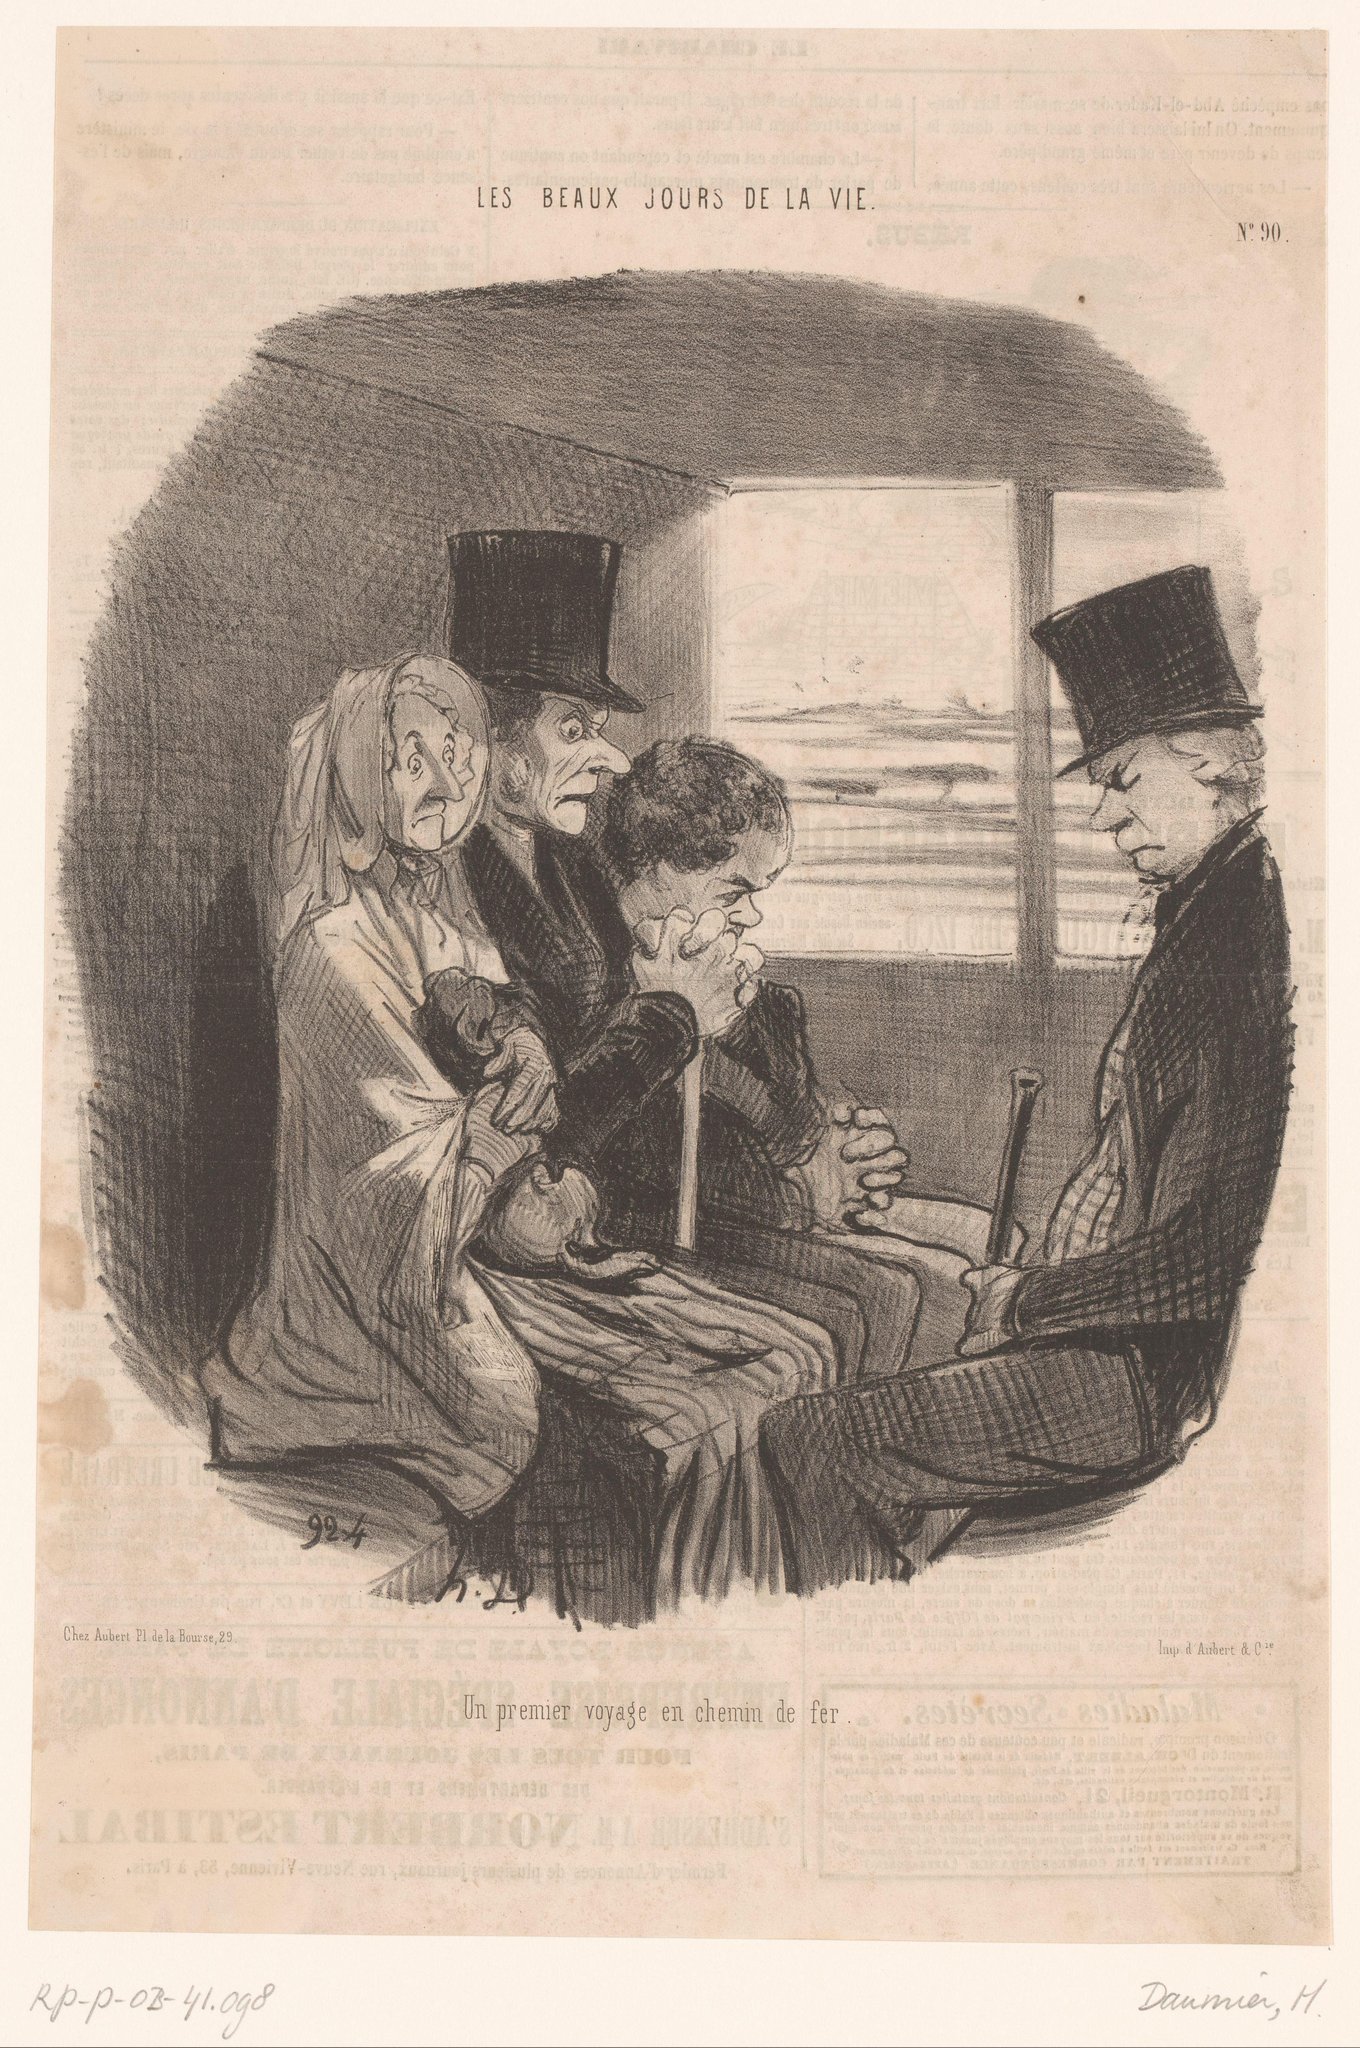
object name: cartoon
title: Les beaux jours de la vie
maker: honoré daumier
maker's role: draughtsman, painter, print maker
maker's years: 1808-1879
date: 1846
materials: paper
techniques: lithograph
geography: paris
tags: caricatures (human types), passenger train (+ four persons or more ~ traffic and transport)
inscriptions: collector's mark: Lugt 2228a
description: Prent gebruikt voor: Le Charivari, 19-07-1846.